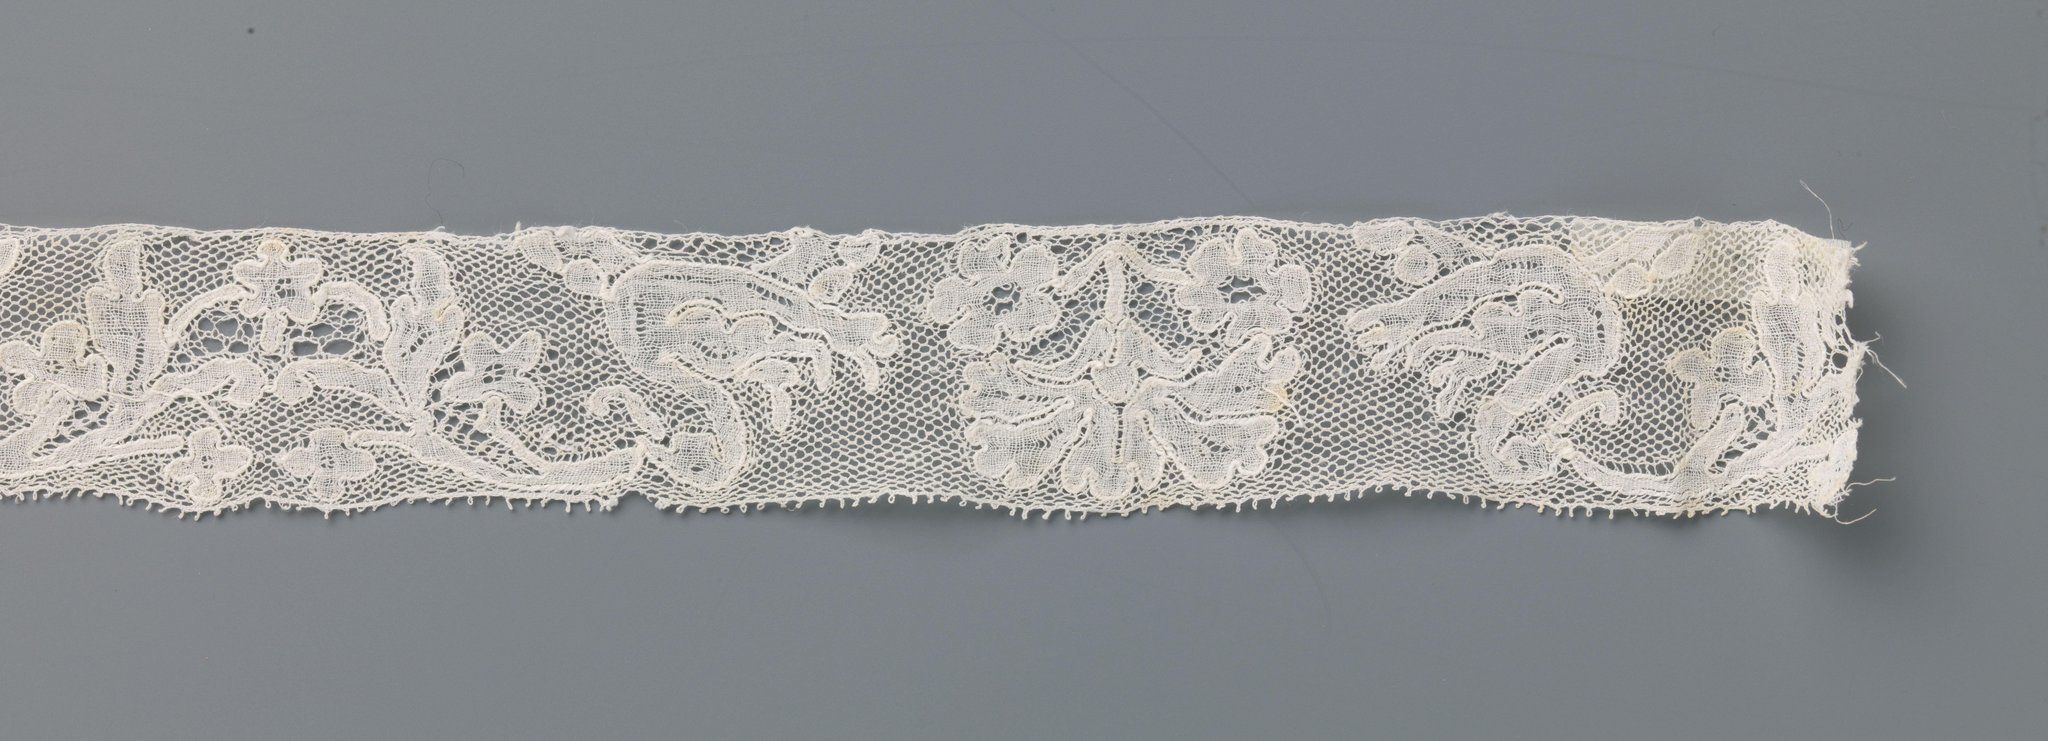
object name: strip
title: Strook kloskant met zwaantjes en anjers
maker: Anonymous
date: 1725-1749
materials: linen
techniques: lace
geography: mechelen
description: Strook naturelkleurige kloskant: Mechelse kant. Het zich herhalende patroon bestaat uit een symmetrische compositie met twee zwaantjes, links en rechts geflankeerd door een losstaande anjer tussen twee rozetbloempjes. De motieven zijn met elkaar verbonden door een fijne maasgrond, de Mechelse grond. De motieven zijn gemaakt in linnenslag met uitsparingen, en voorzien van dikkere en glimmende contourdraden. Er zijn spaarzaam enkele siergronden toegepast, tussen de takken die de zwanen met hun snavel vasthouden en in de rozetbloempjes. Boven- en onderzijde zijn recht afgewerkt, met langs één zijde picots.